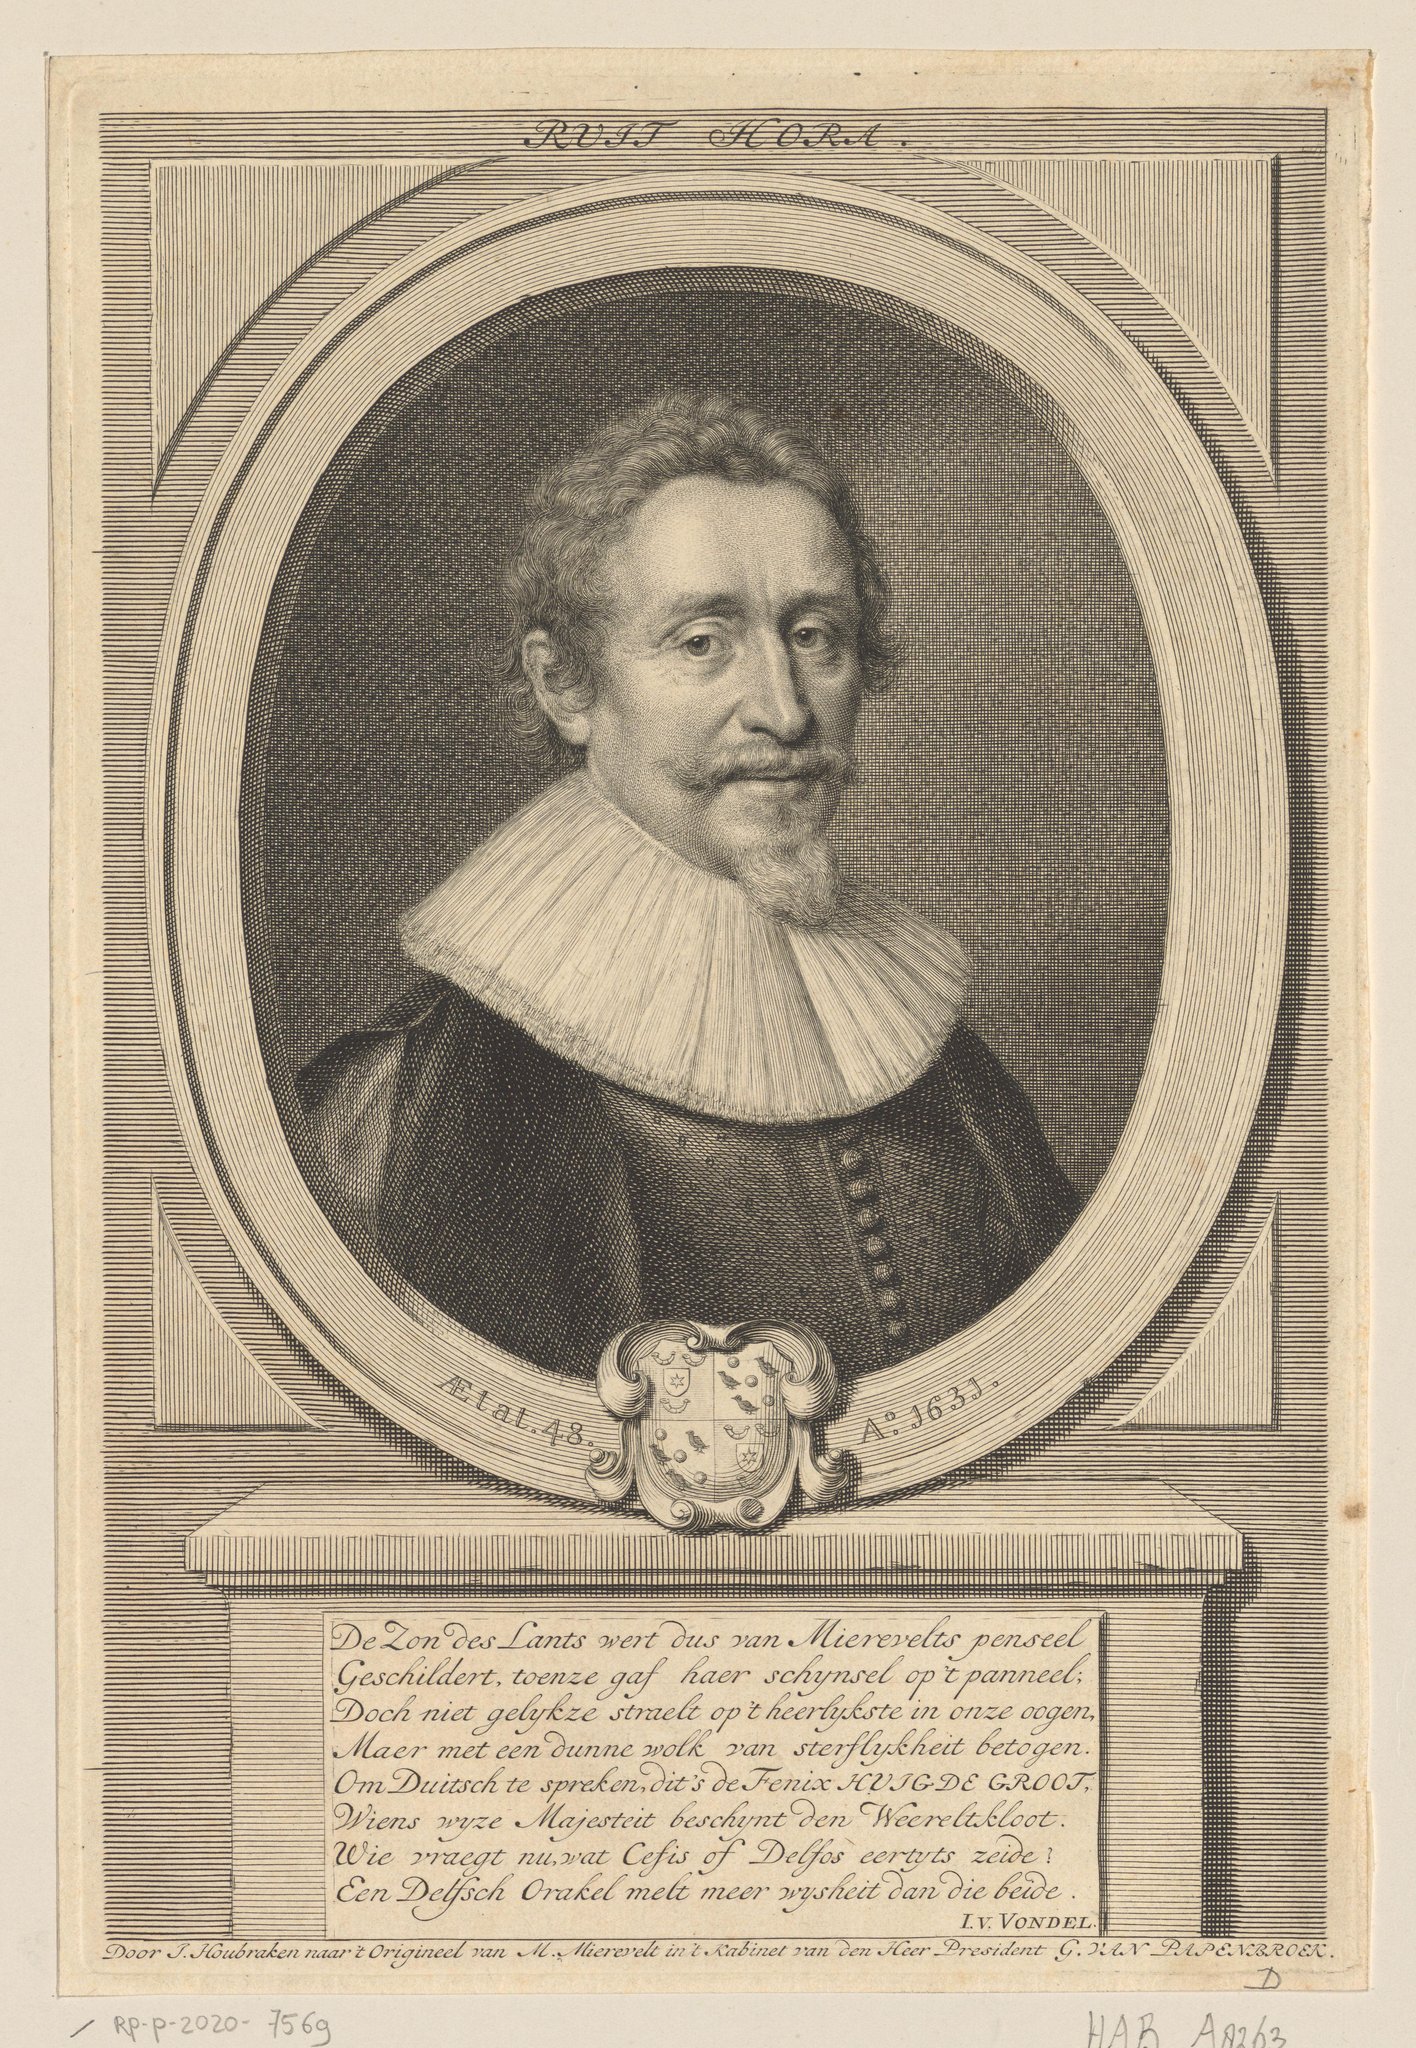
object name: print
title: Portret van Hugo de Groot op 48-jarige leeftijd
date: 1631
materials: paper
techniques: engraving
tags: delft, hugo de groot, historical persons, portrait of a writer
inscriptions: date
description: Tekst in het Nederlands in de ondermarge.